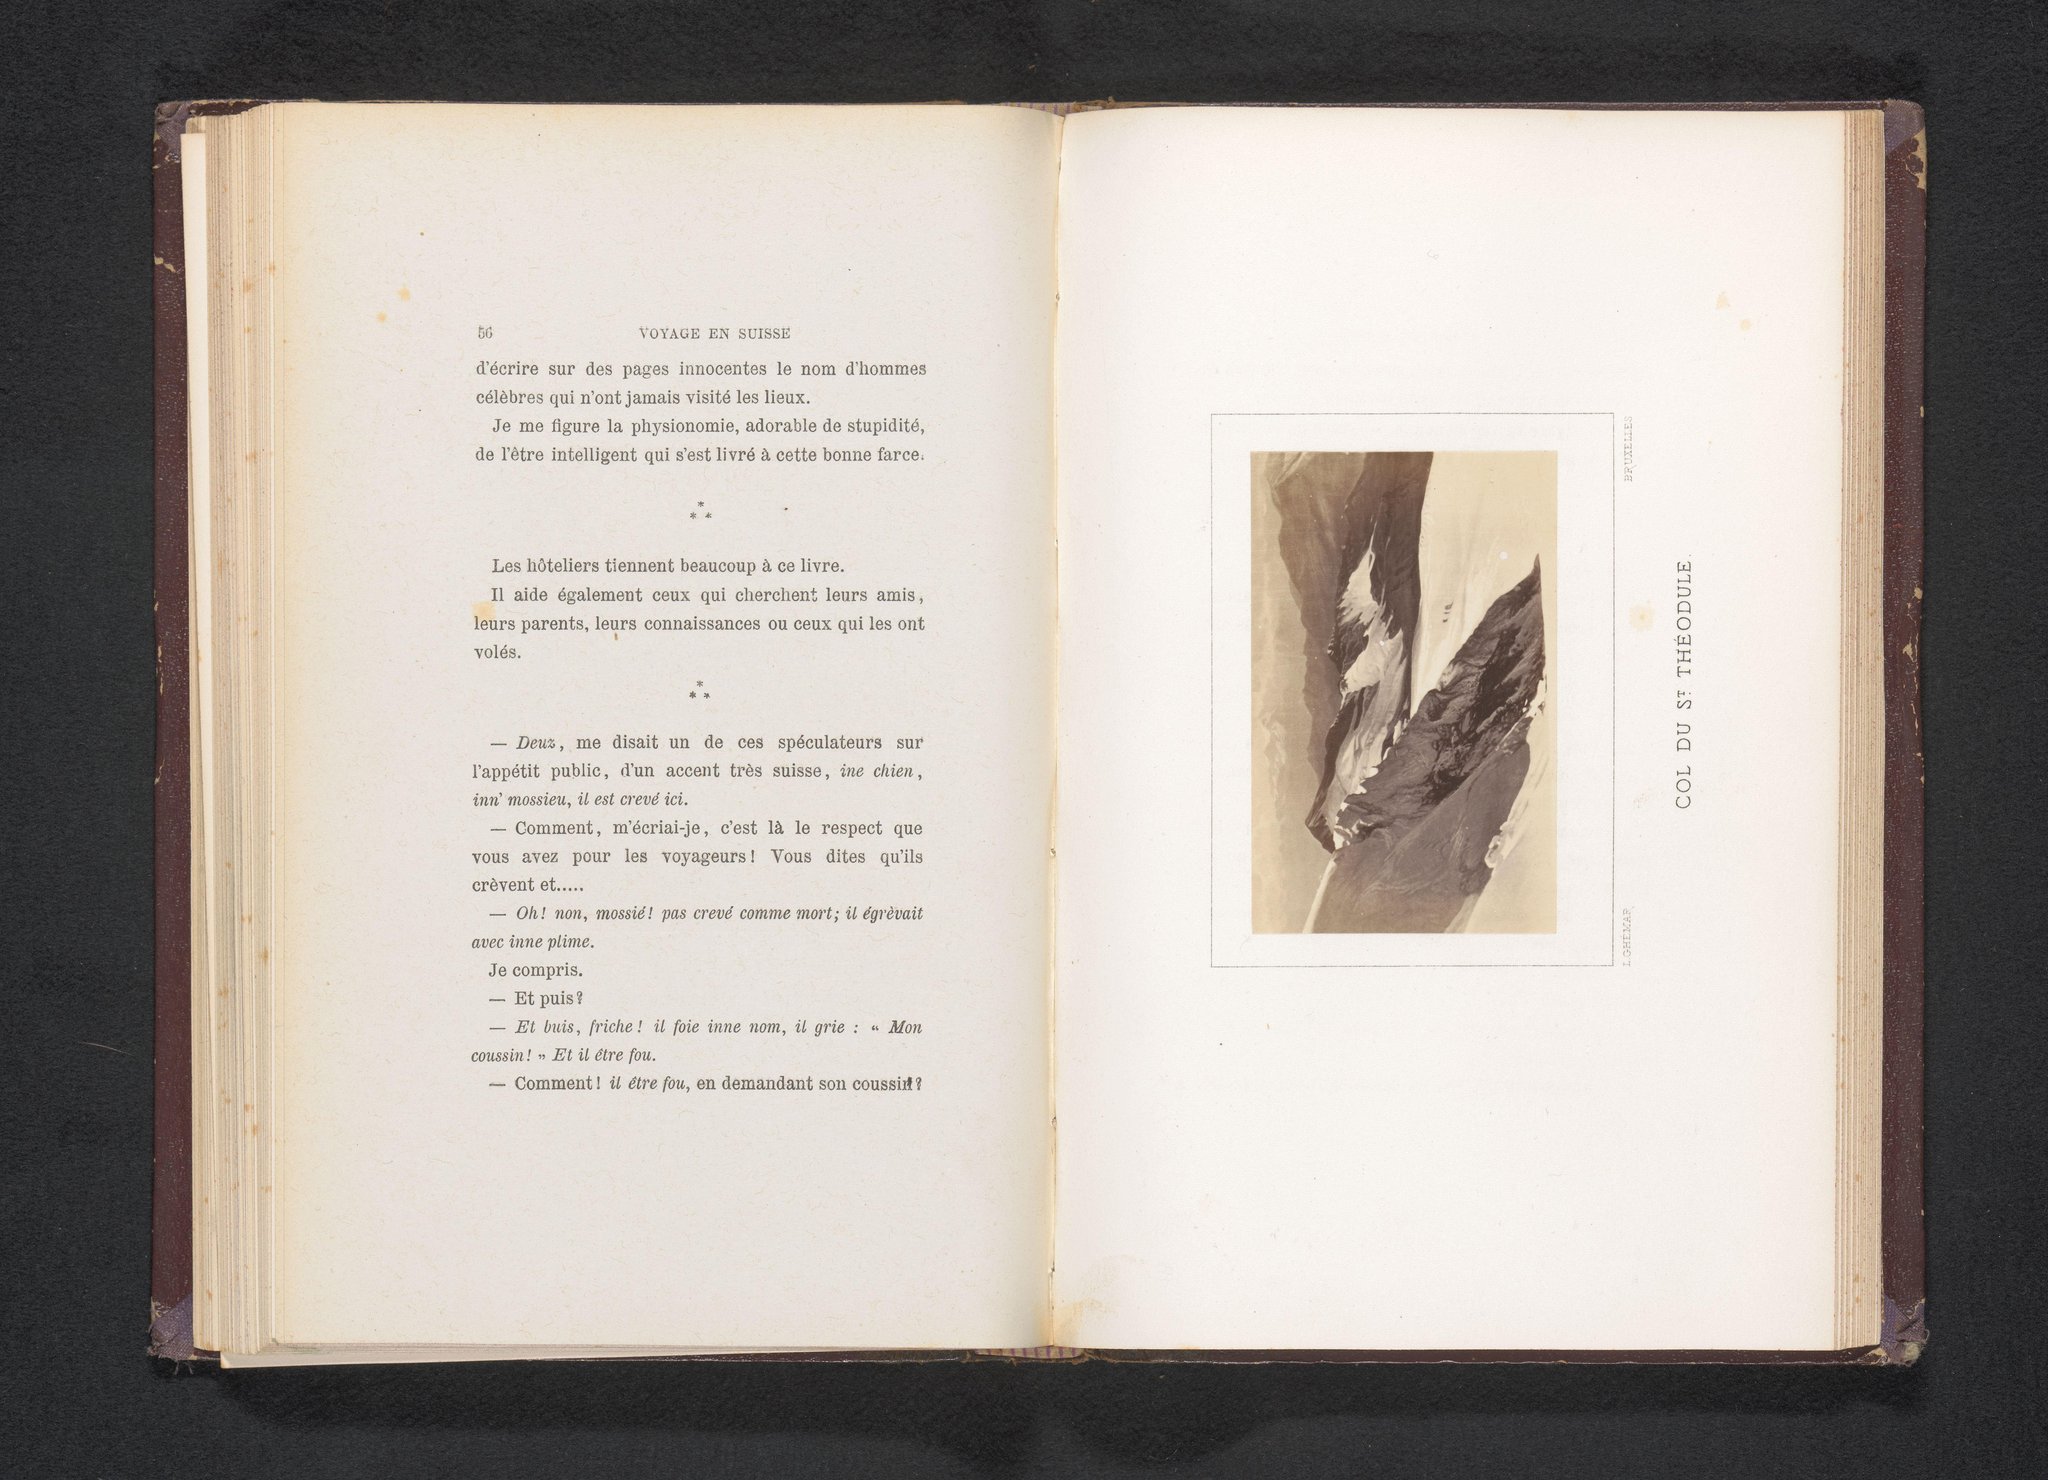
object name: photograph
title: Col du St. Théodule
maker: louis ghémar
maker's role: draughtsman, print maker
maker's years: 1819-1873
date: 1863-1868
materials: photographic support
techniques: albumen print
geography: wallis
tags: mountain climbing, mountaineering, mountain-range, snow peaks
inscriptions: inscription: ‘Bruxelles’